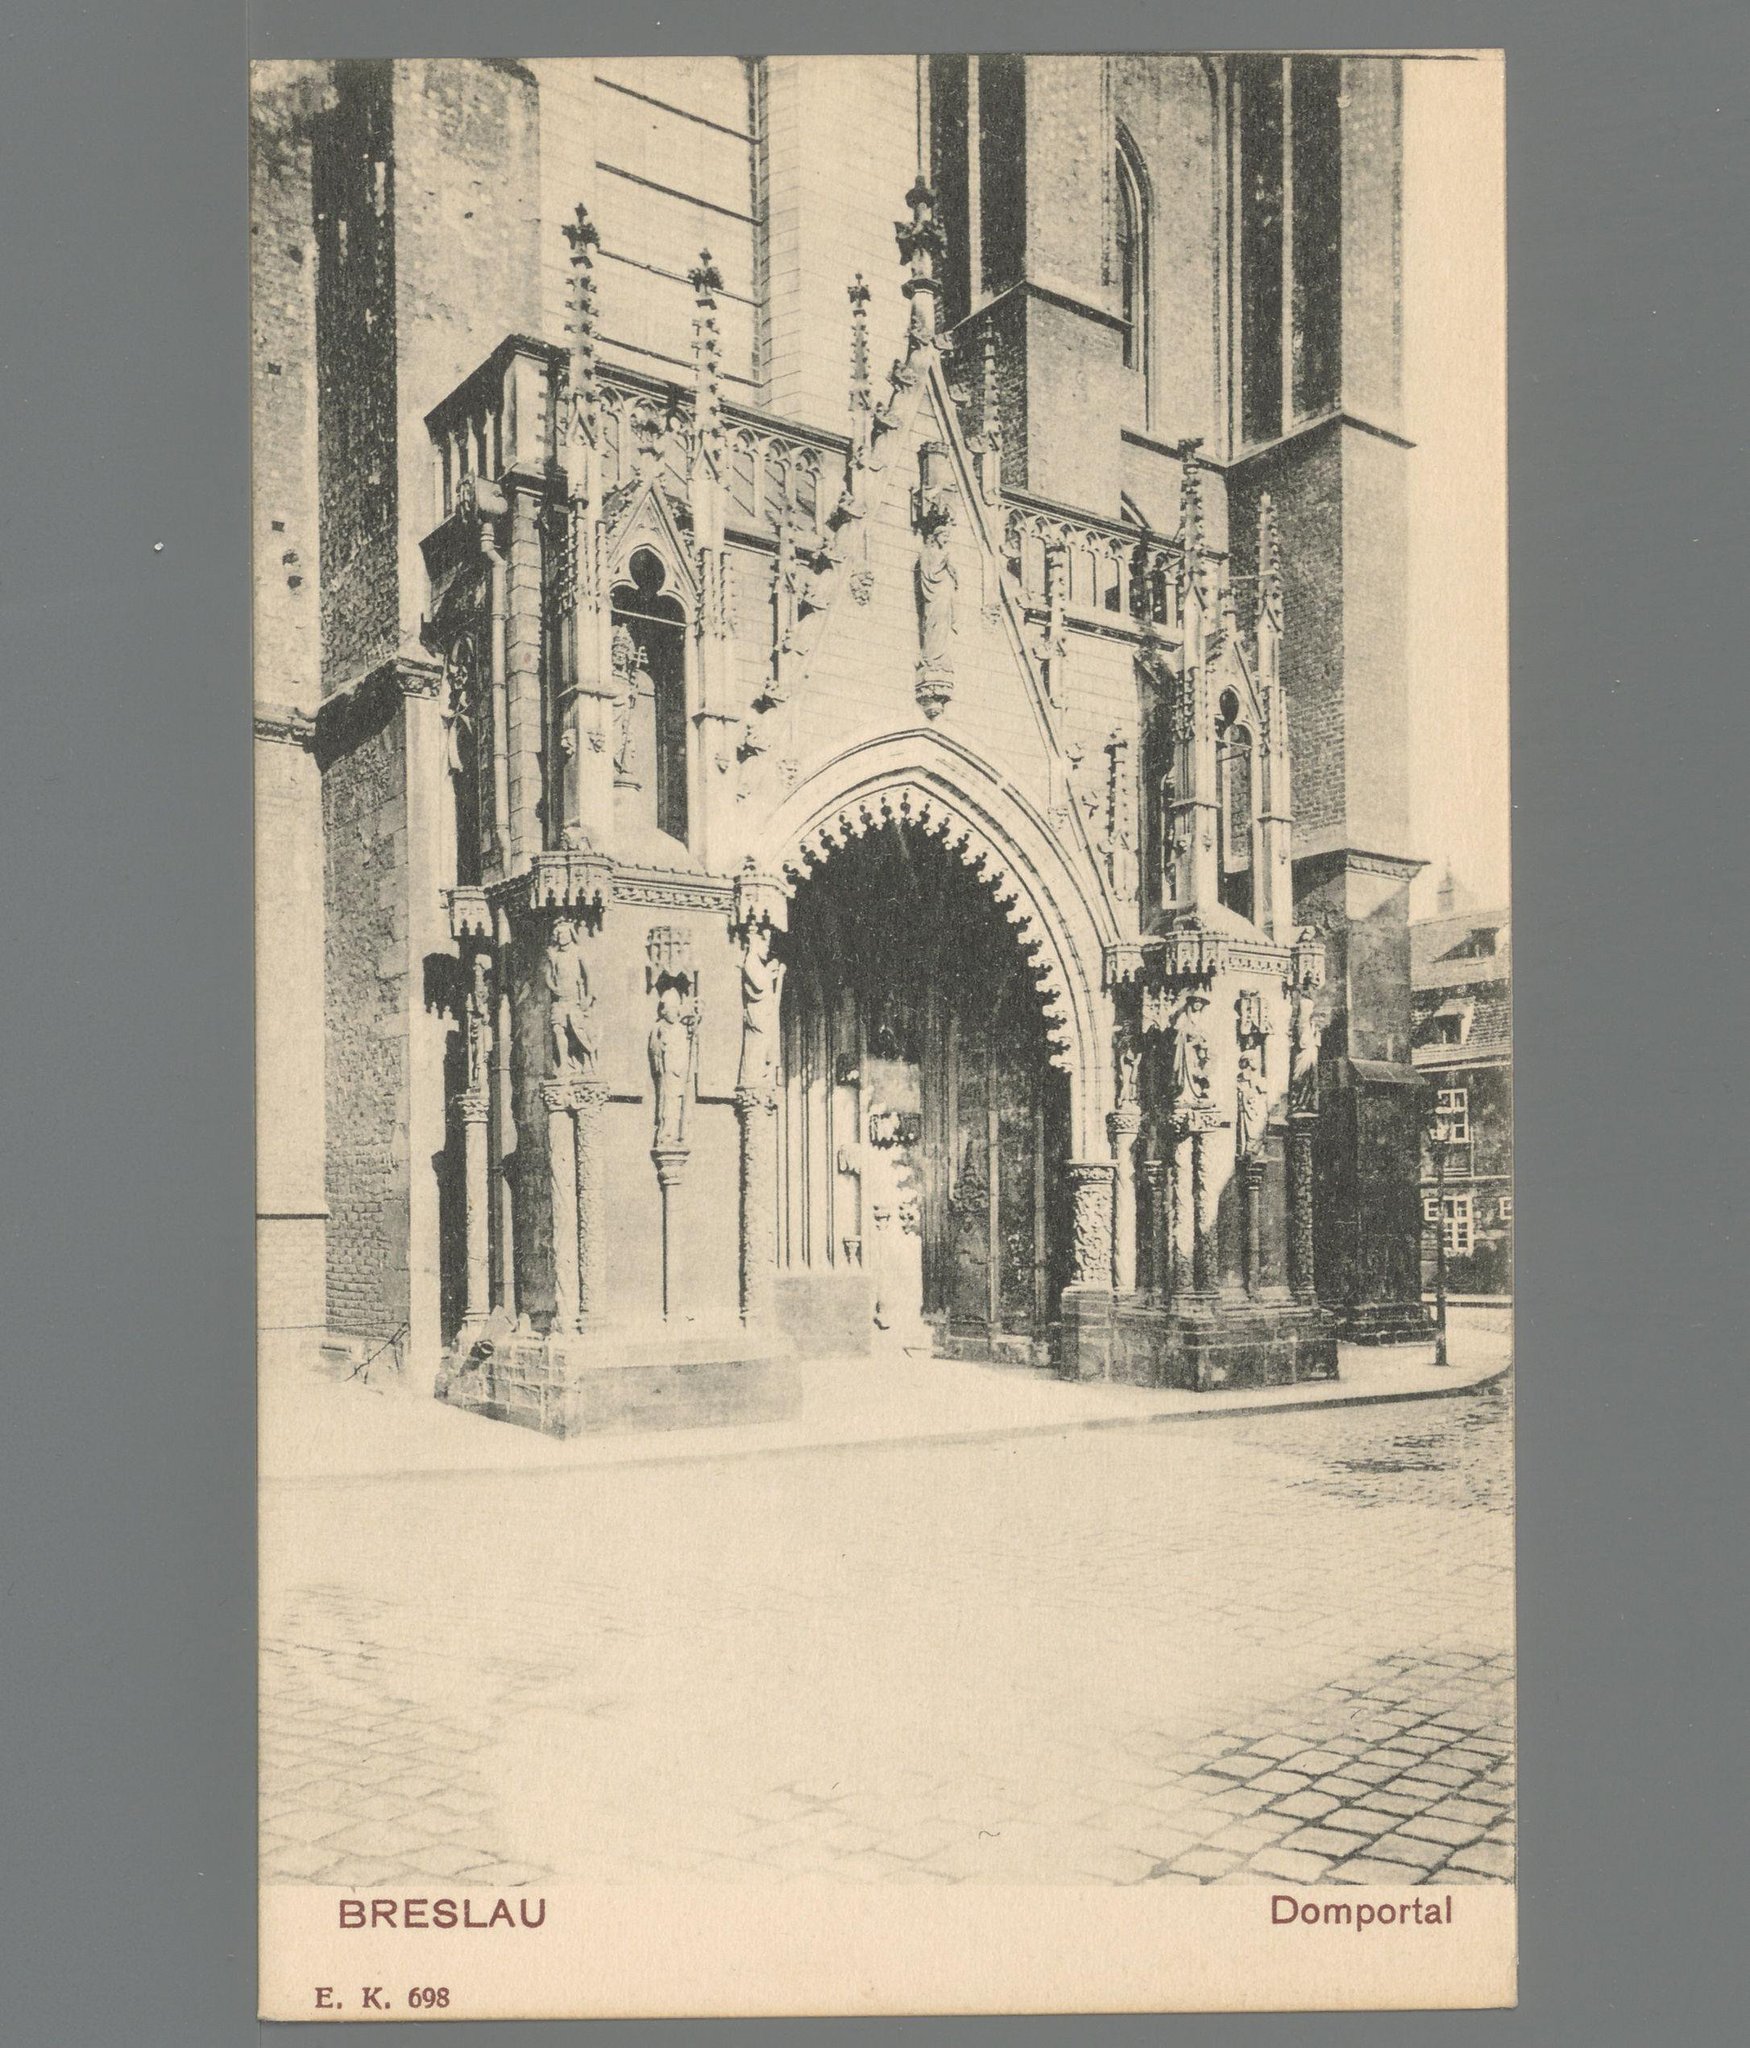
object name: ansichtkaart, prentbriefkaart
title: Breslau. Domportal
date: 1905-1930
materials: cardboard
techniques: photograph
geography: breslau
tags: church (exterior), gate, entrance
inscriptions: monogram: ‘E.K.’